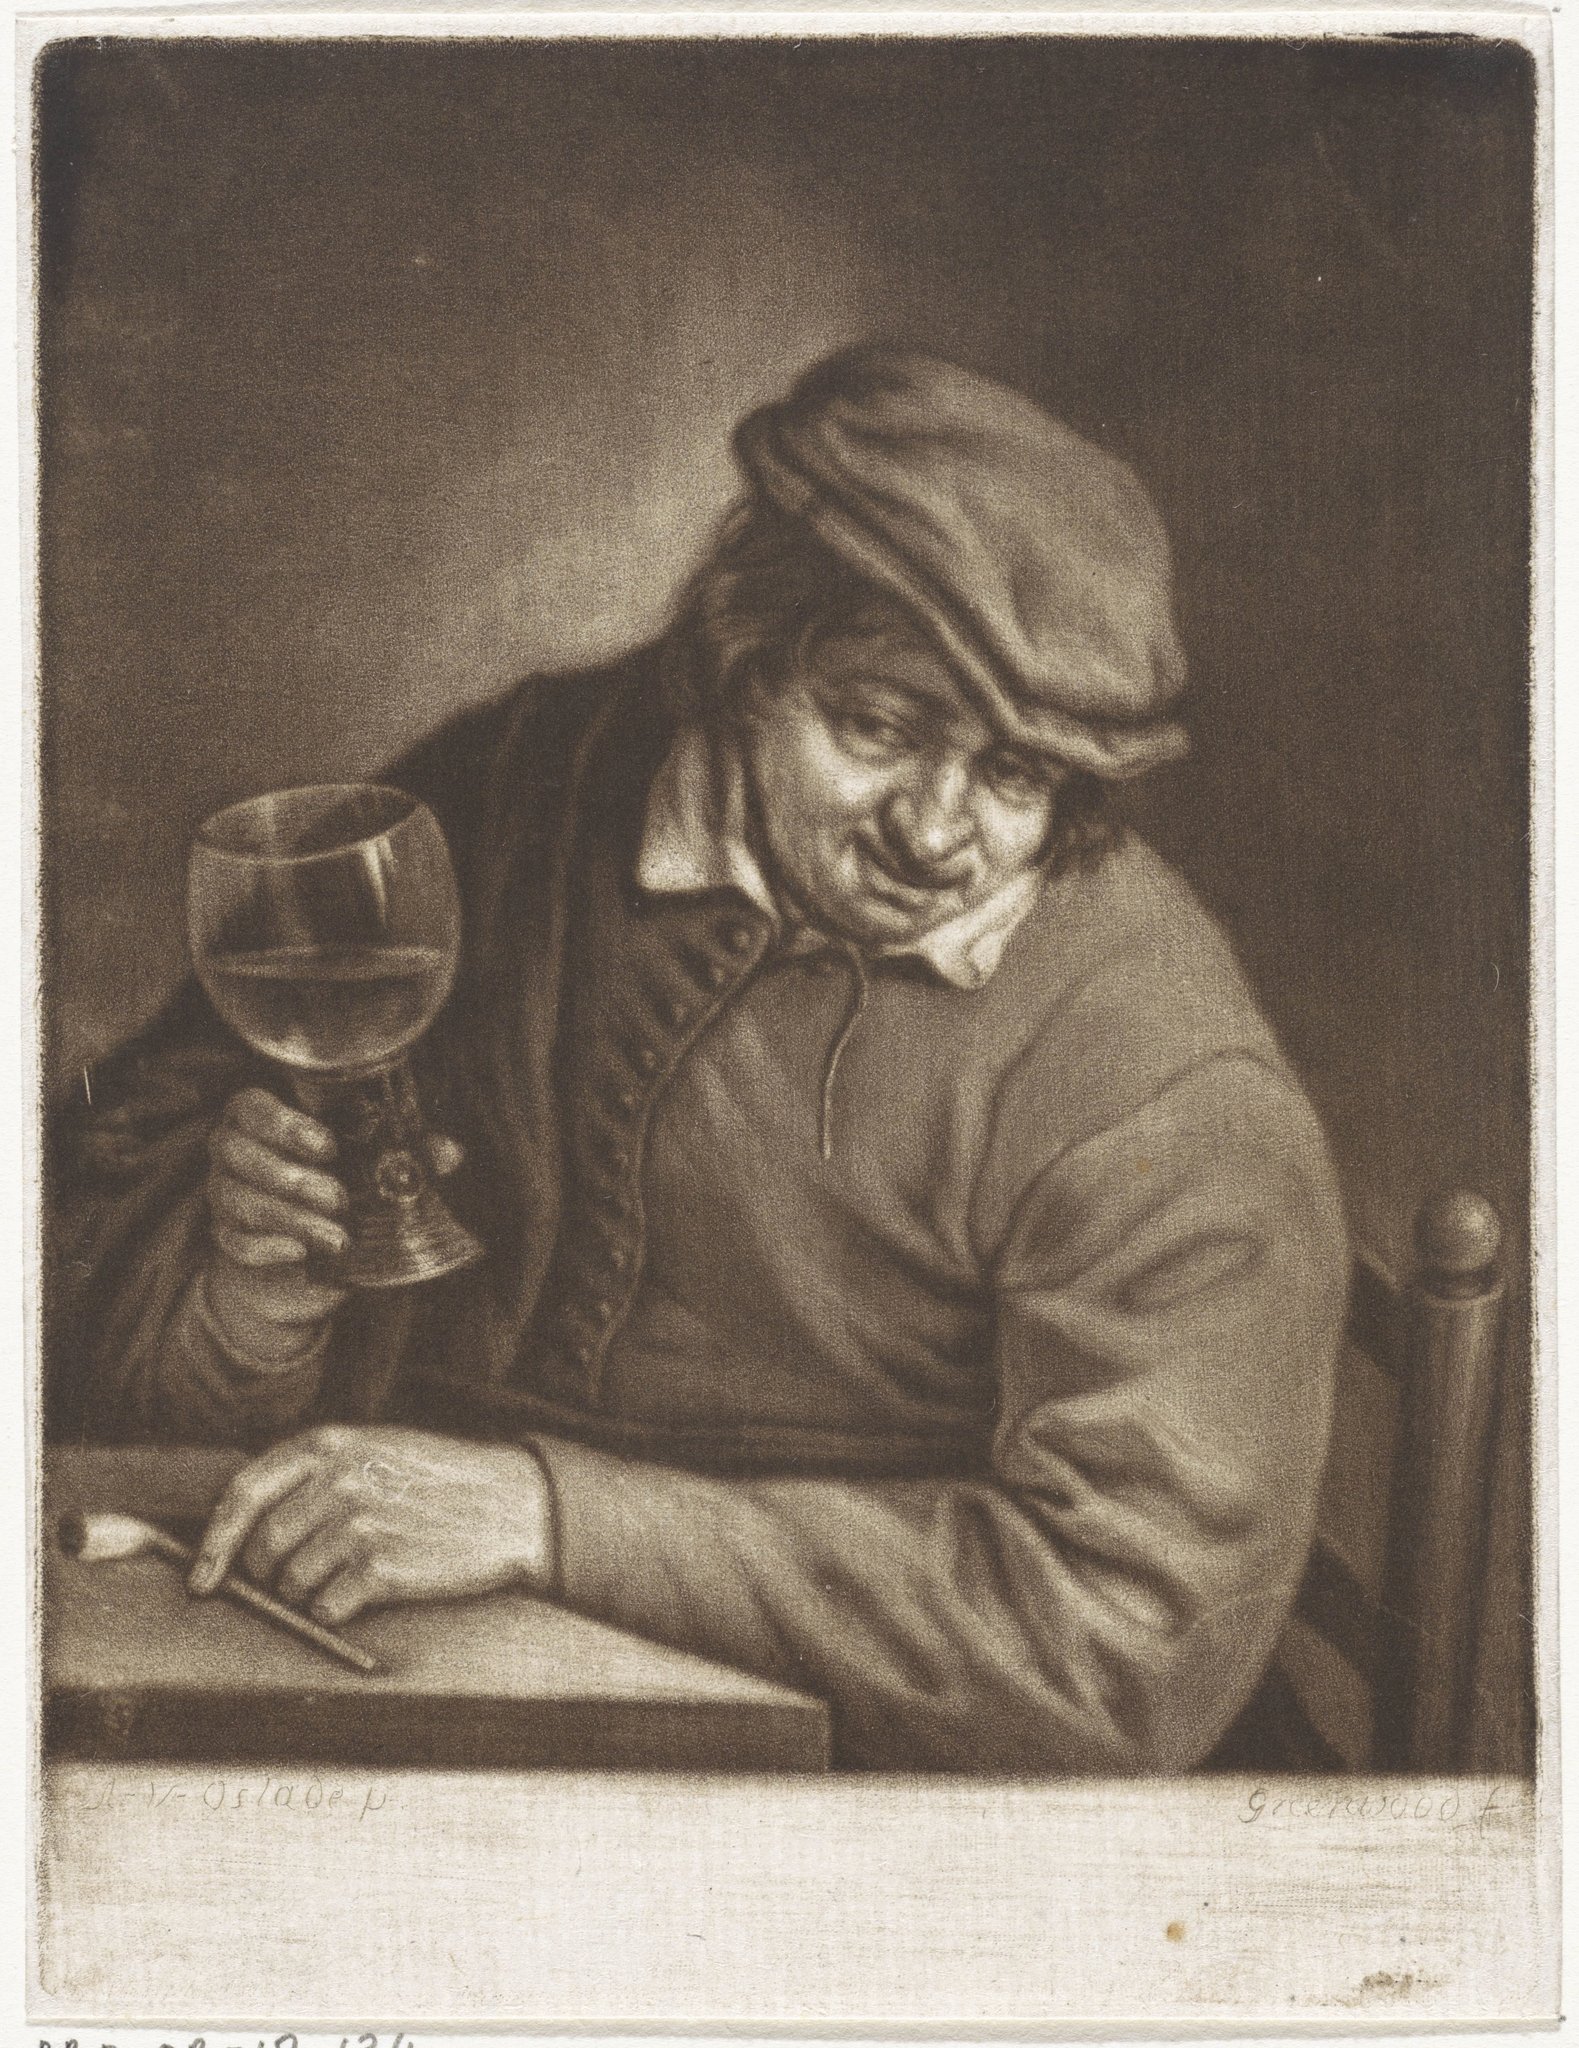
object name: print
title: Man met een roemer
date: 1739-1792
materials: paper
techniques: print in brown, mezzotint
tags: pipe ~ tobacco, glass, rummer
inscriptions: collector's mark: Lugt 240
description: Een man zit aan een tafel. In zijn hand een roemer en op de tafel een pijp.